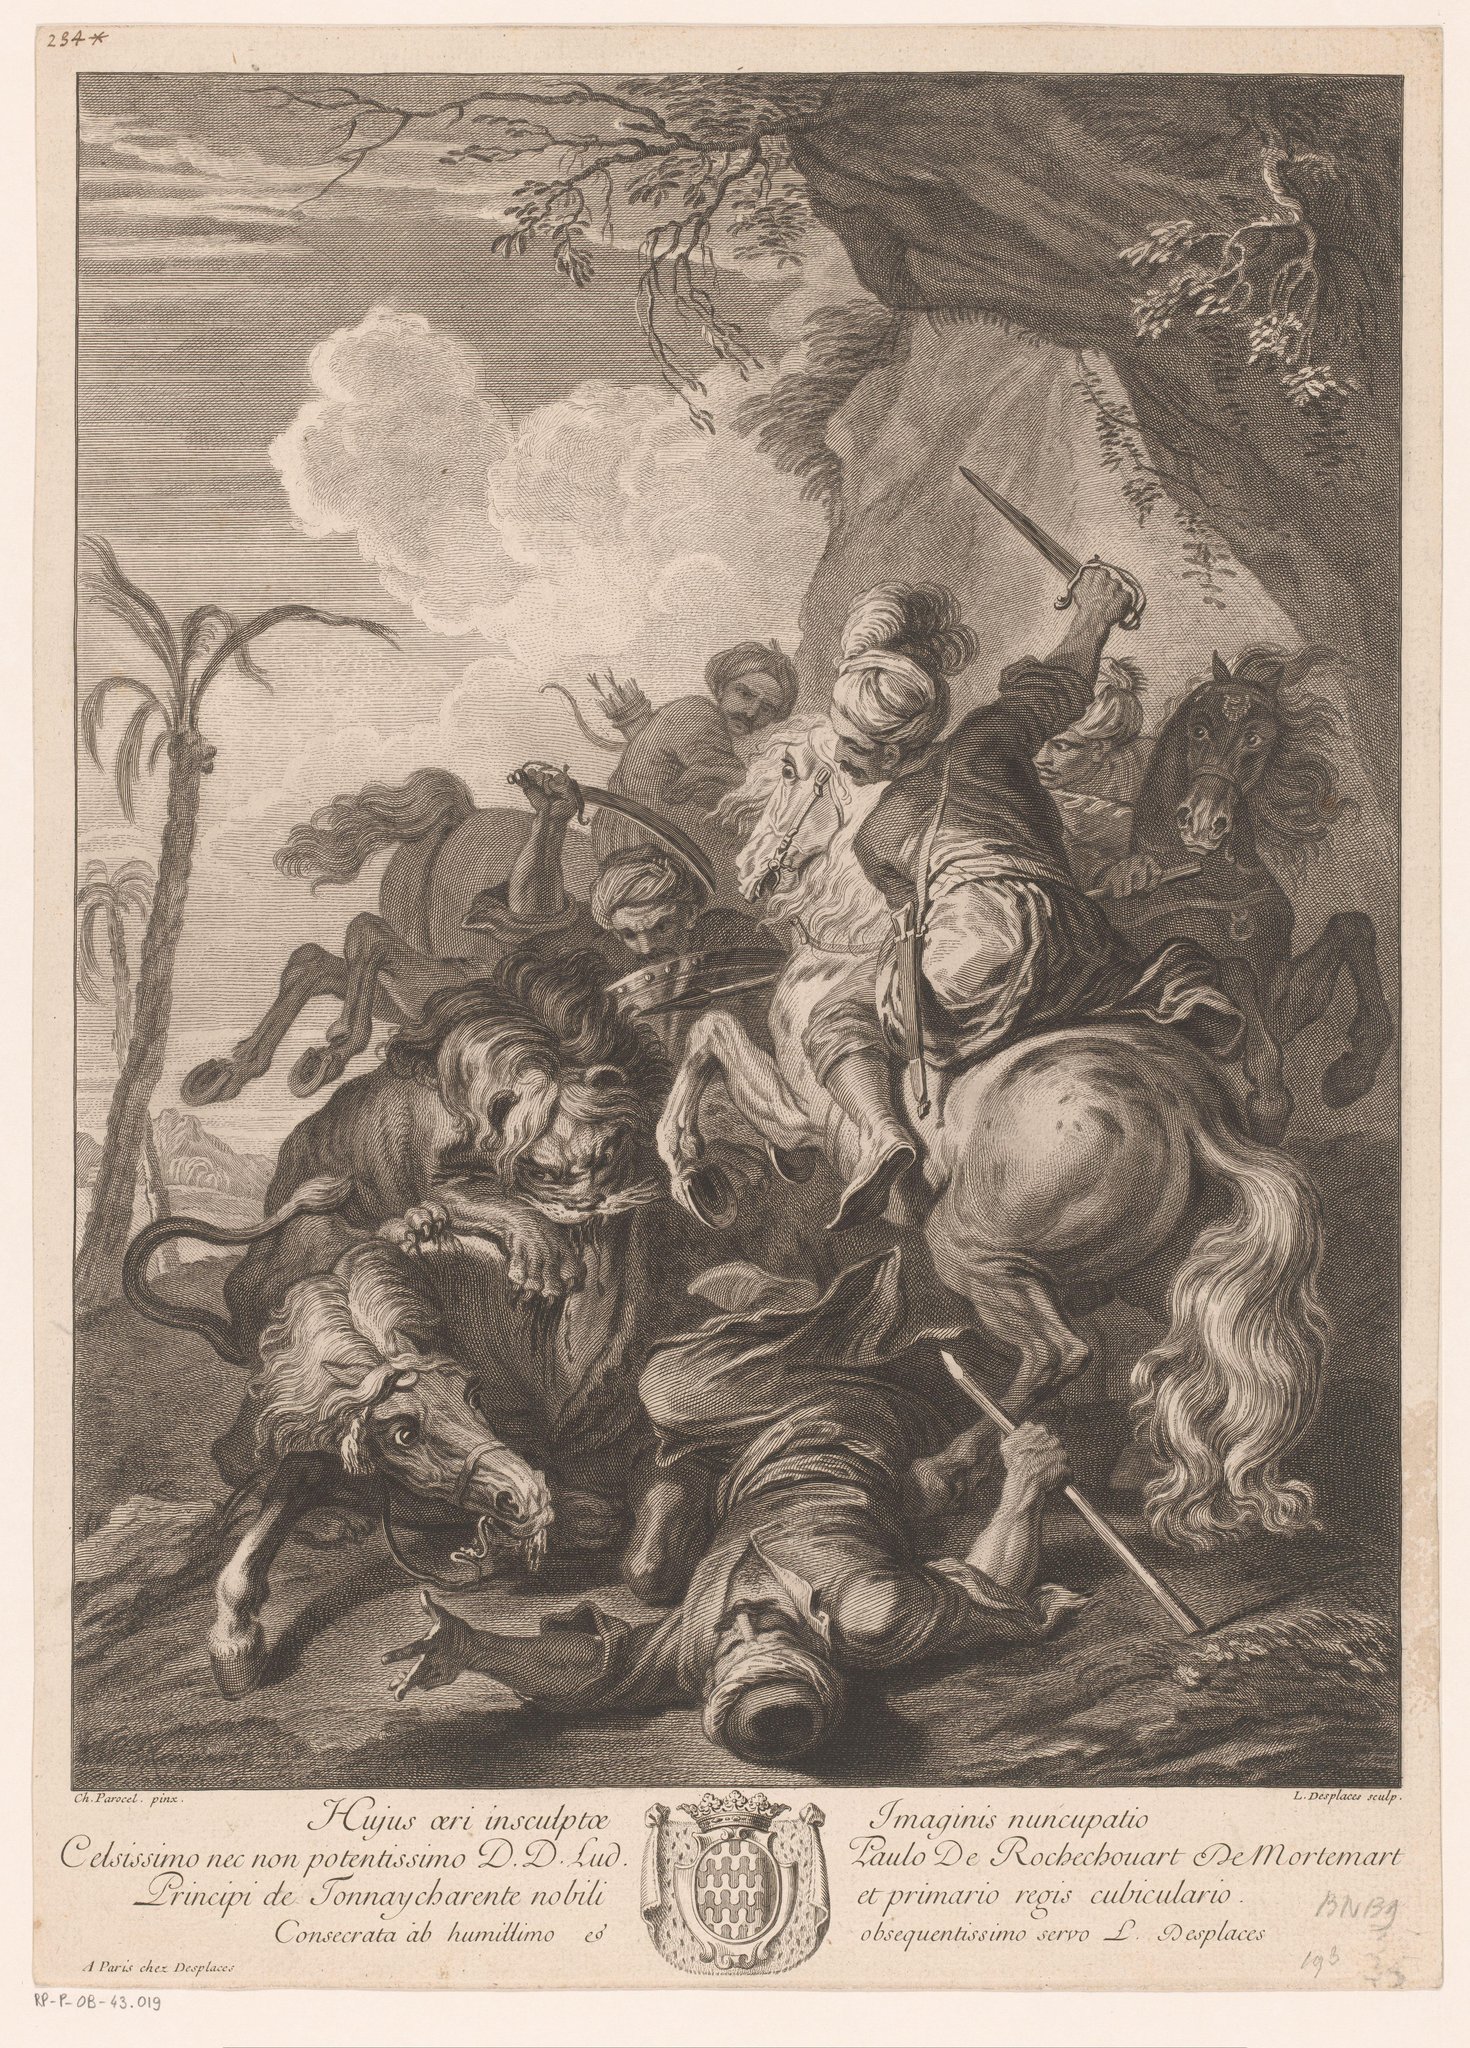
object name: print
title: Leeuwenjacht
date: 1731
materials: paper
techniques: engraving, etching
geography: france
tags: lion hunt, beasts of prey, predatory animals: lion, armorial bearing, heraldry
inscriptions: collector's mark: Lugt 240